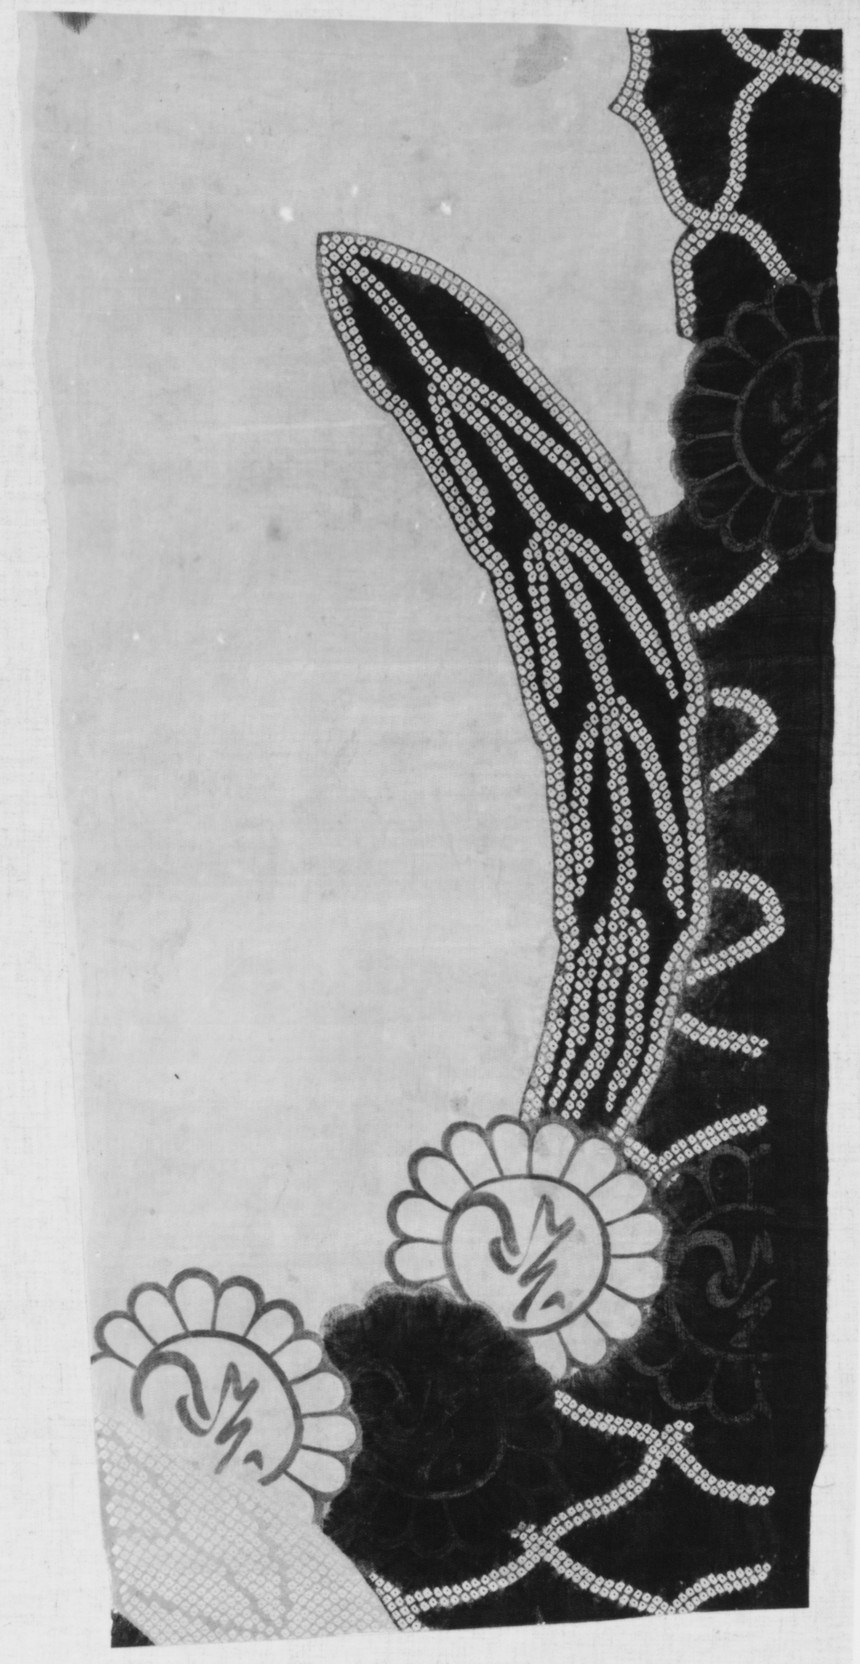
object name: piece from a kosode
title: Kosode Fragment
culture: japanese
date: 1651-1700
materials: textile